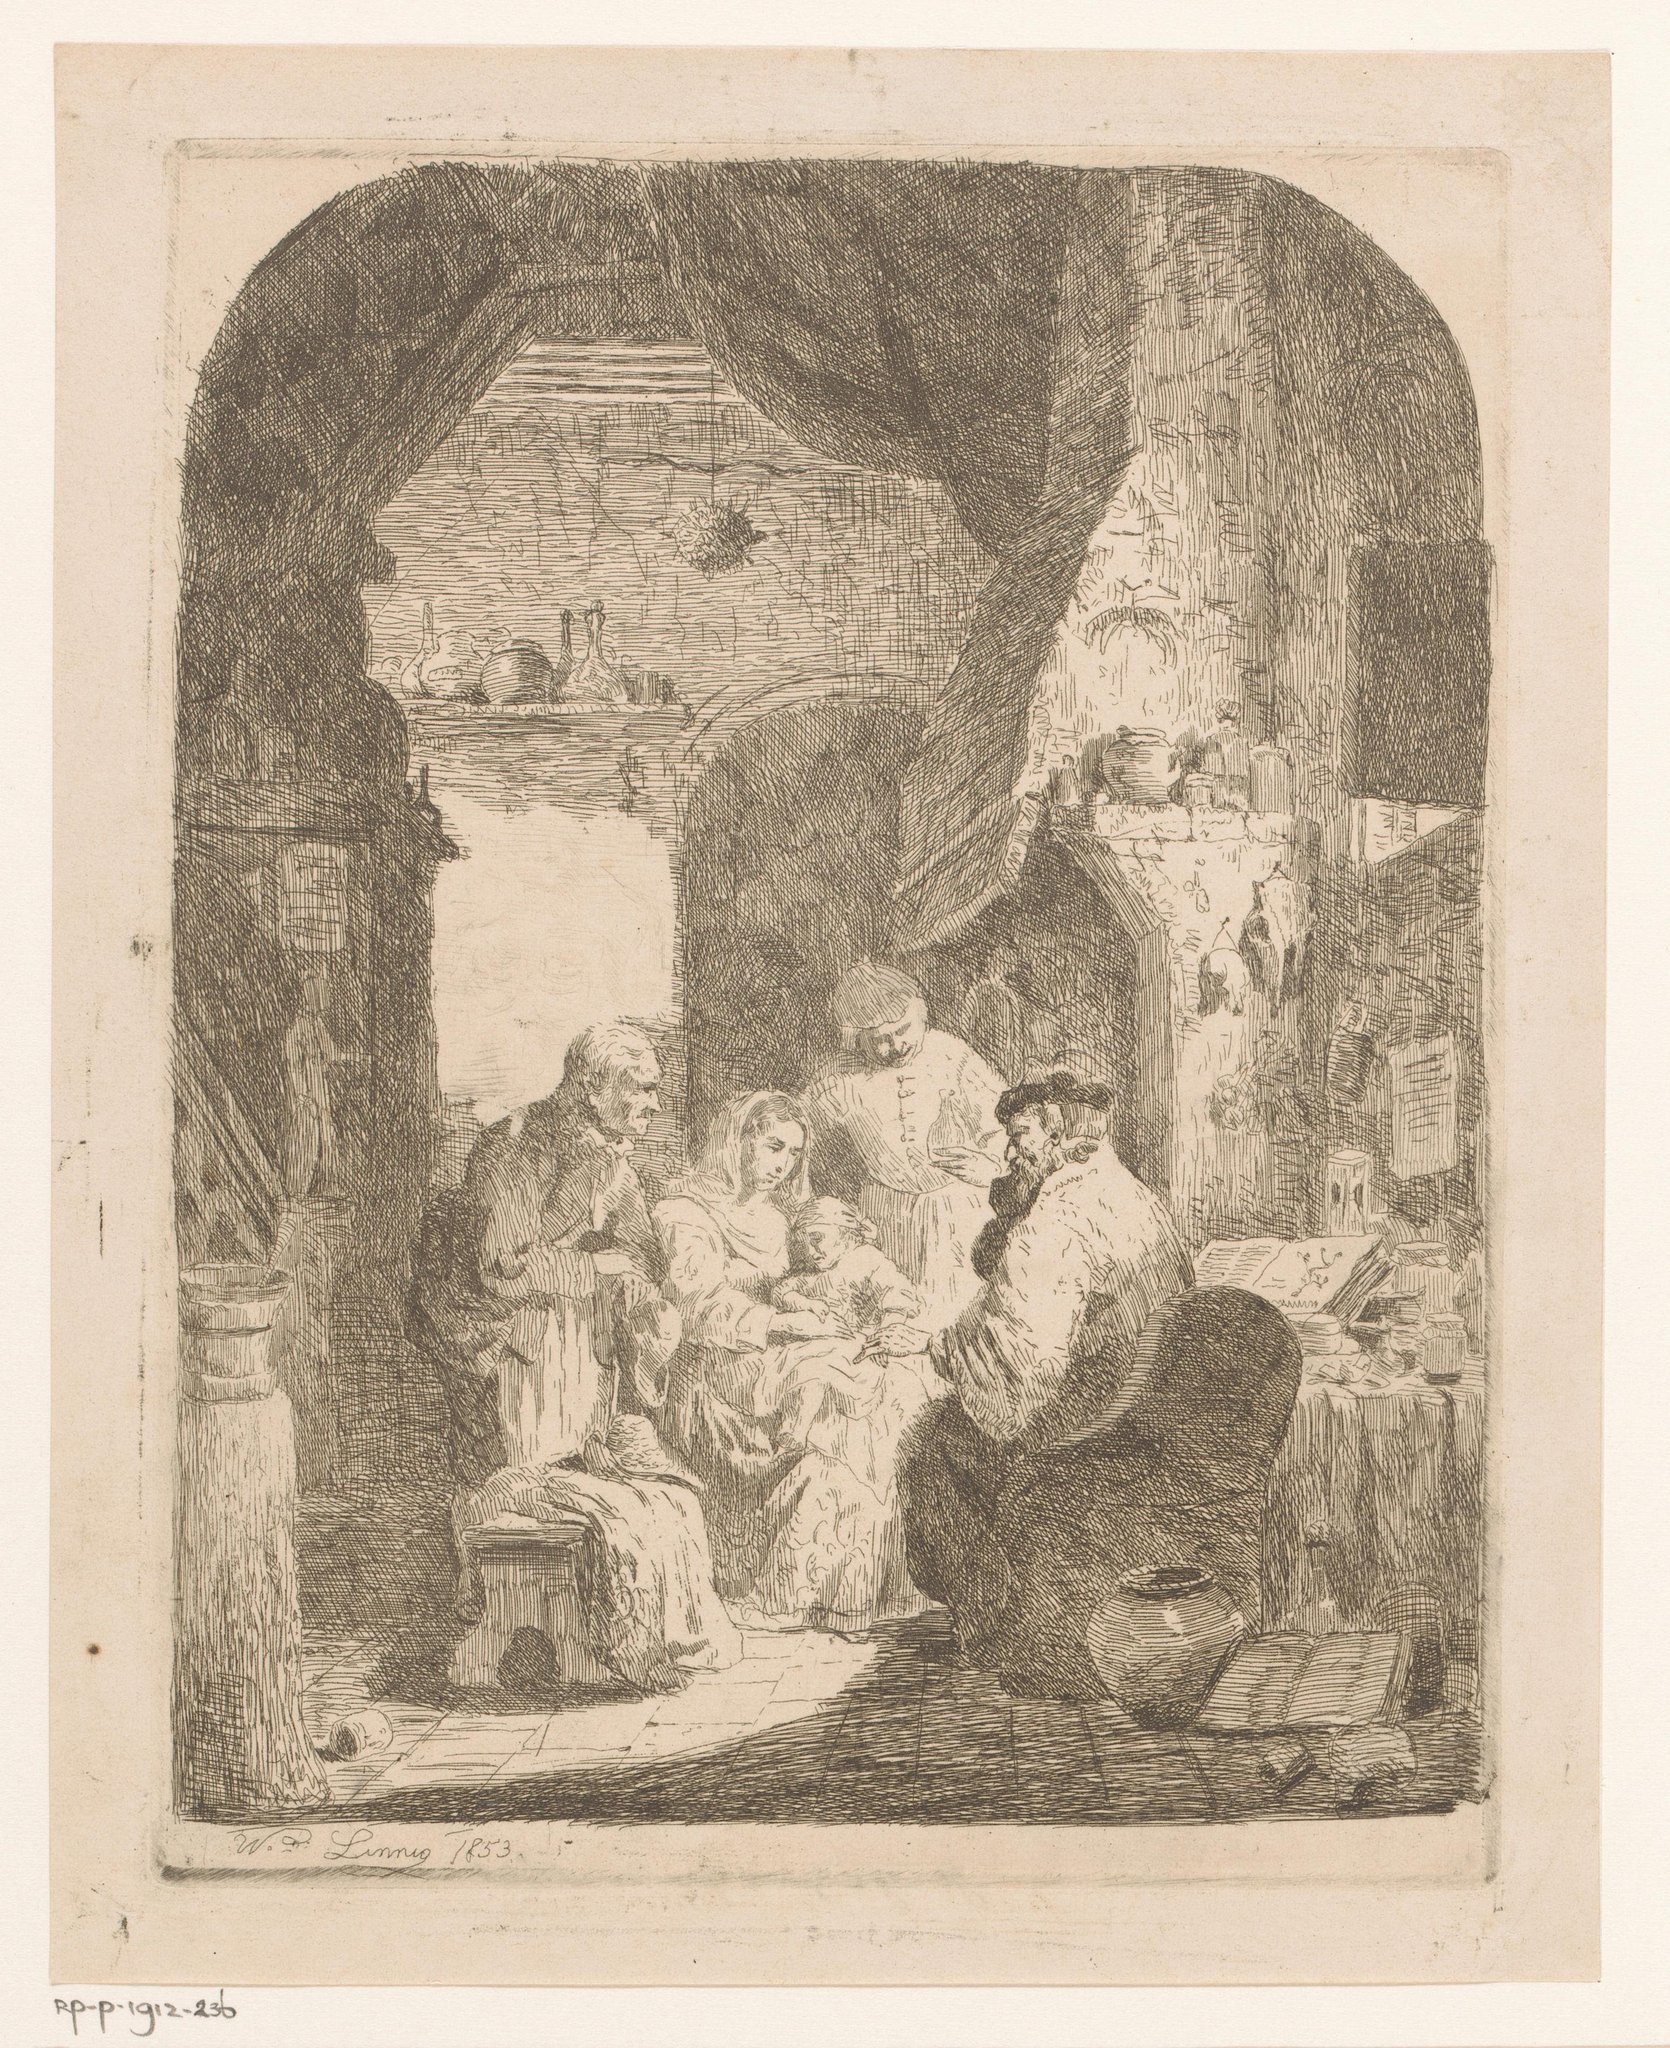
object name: print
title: Gezin met een ziek kind bij de dokter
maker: willem linnig (i)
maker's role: print maker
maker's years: 1819-1885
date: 1853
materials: paper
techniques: etching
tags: physician, doctor, hourglass, (human) skeleton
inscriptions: collector's mark: Lugt 1485, annotation: ‘Il n y a que 2 épreu[ves] de cet état’, collector's mark: Lugt 2228